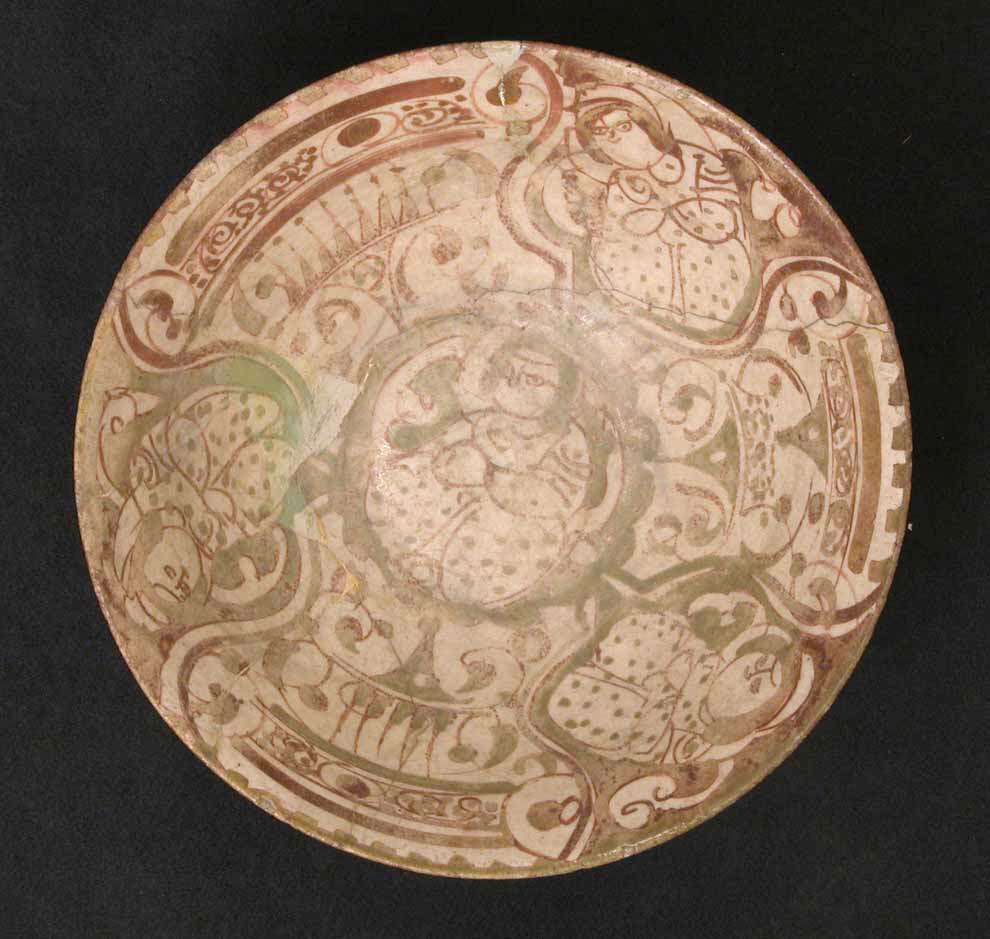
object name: bowl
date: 1101-1300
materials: glaze, stonepaste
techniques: luster painting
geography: iran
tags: human figures